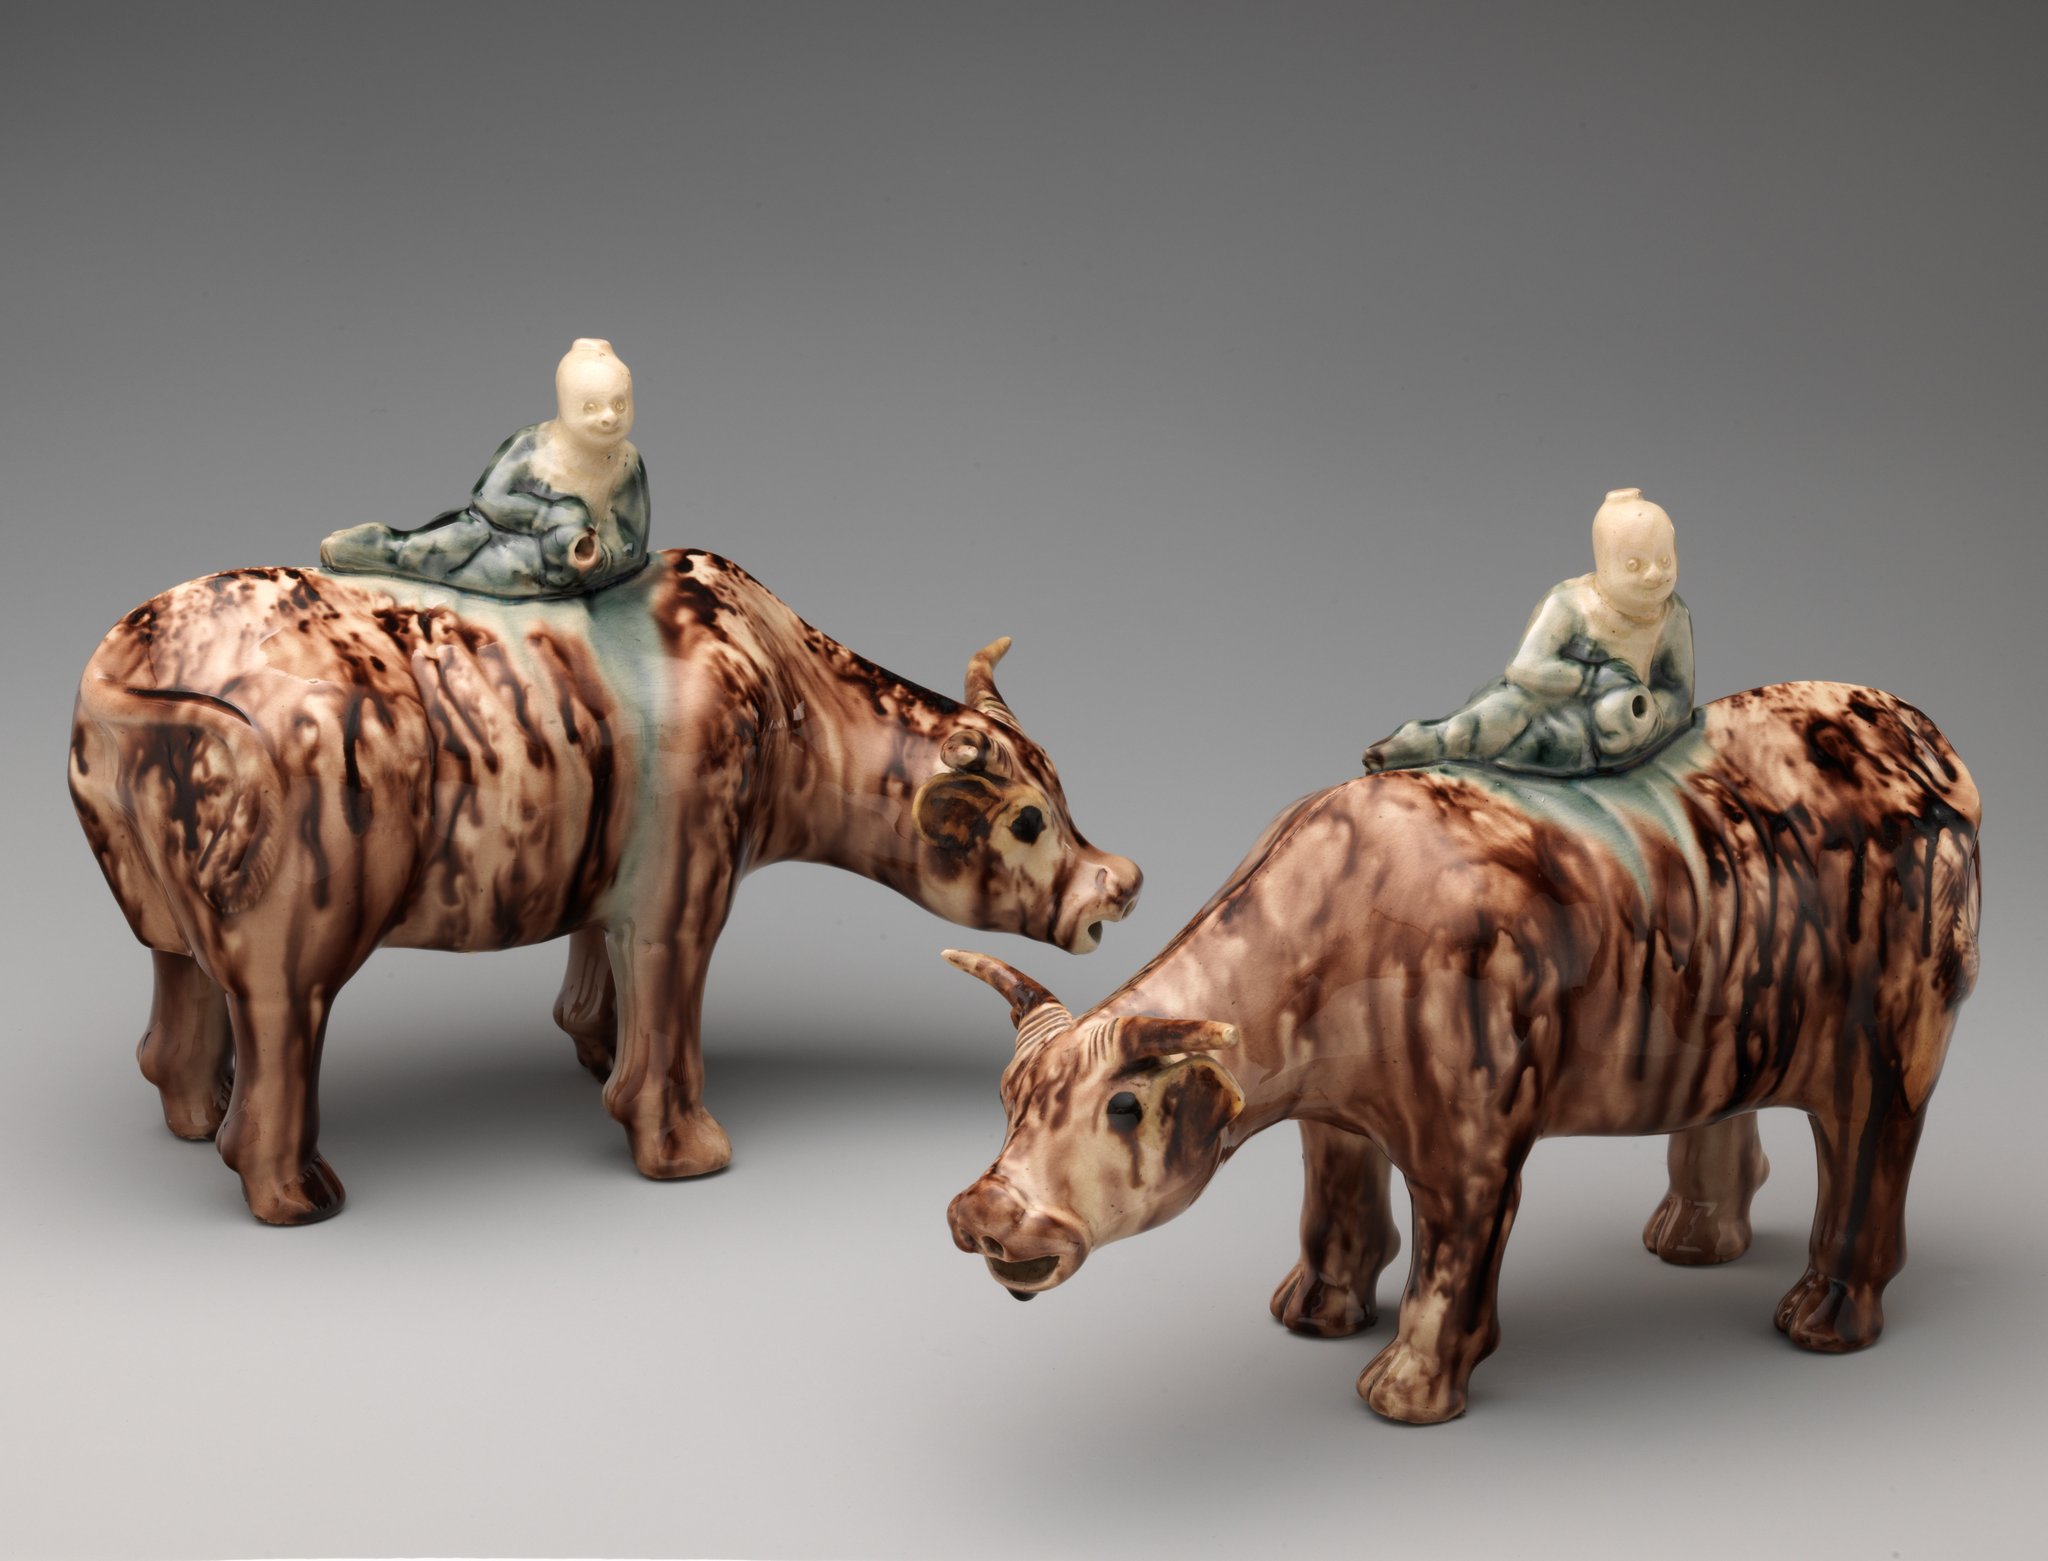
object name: figure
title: Water buffalo and reclining Chinese figure (one of a pair)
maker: whieldon type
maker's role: maker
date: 1760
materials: shell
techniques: glazing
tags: boys,buffalos